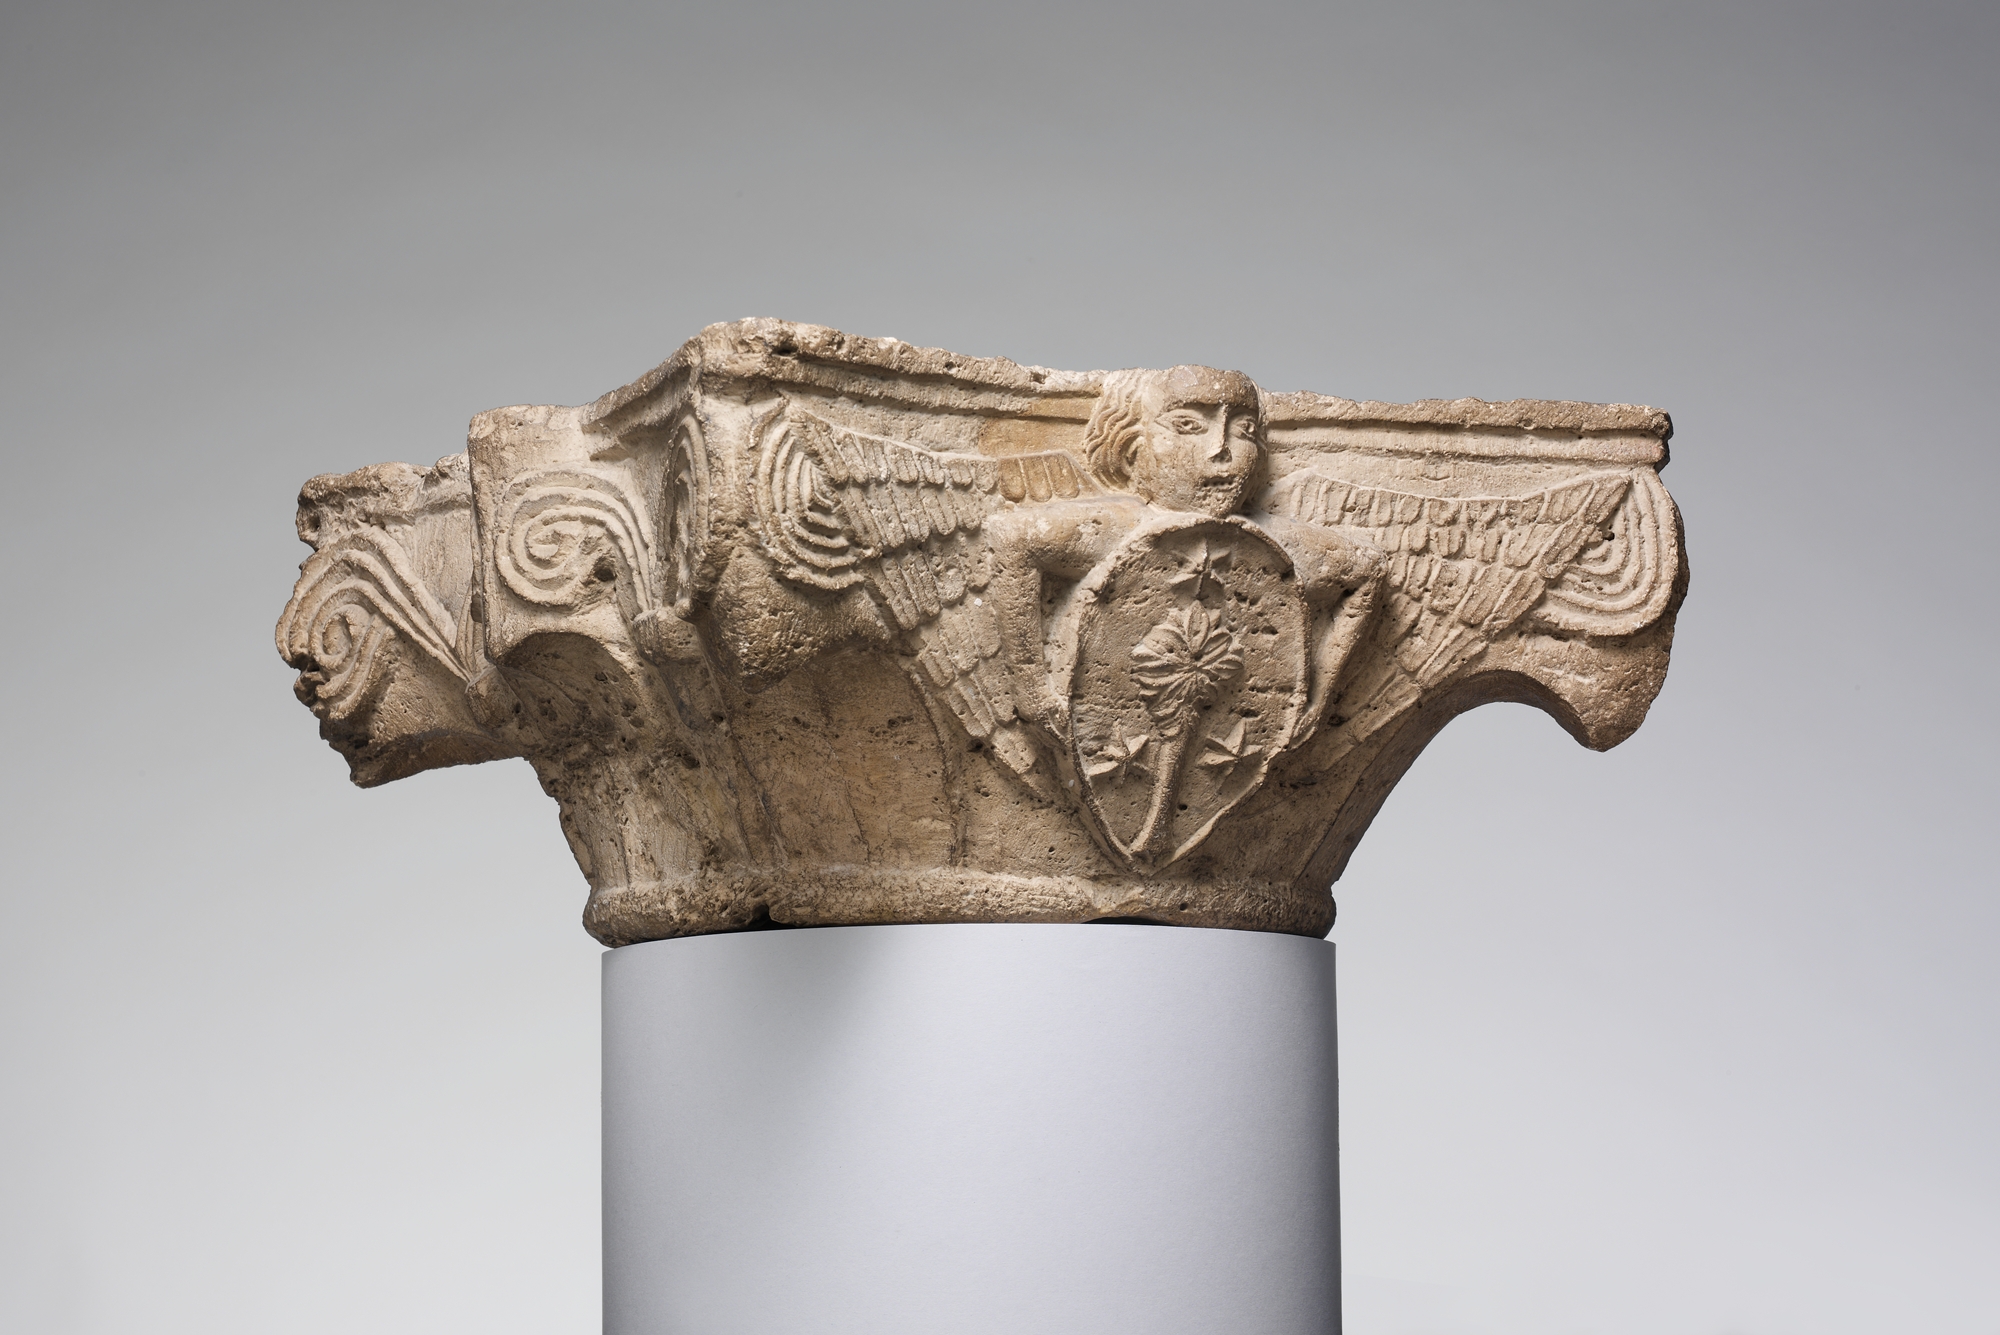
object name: capital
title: Capital with Angel Holding a Shield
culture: northeast italian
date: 701-900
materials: limestone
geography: italy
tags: shields,angels